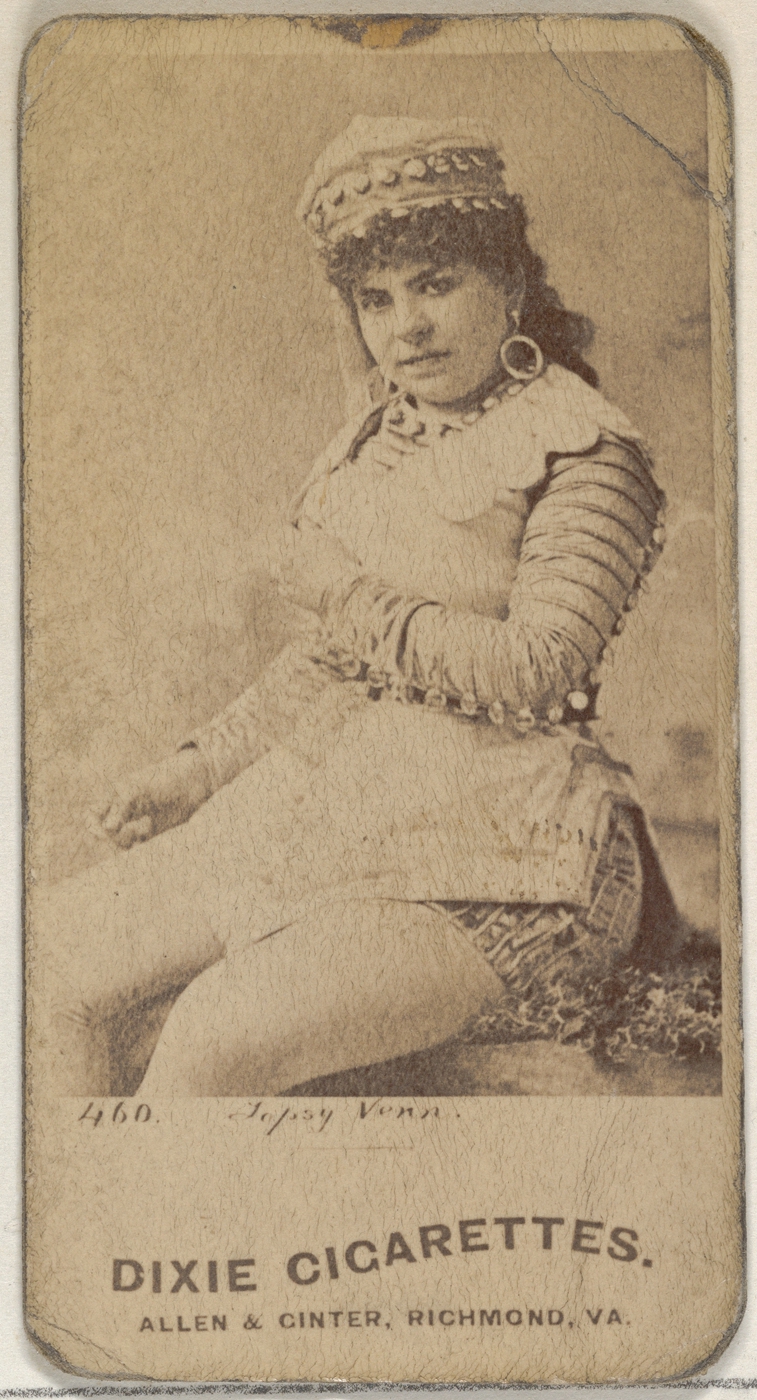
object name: photograph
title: Card 460, Topsy Vonn, from the Actors and Actresses series (N45, Type 7) for Dixie Cigarettes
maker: allen & ginter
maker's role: publisher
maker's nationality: american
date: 1888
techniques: albumen silver print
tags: portraits,women,actresses